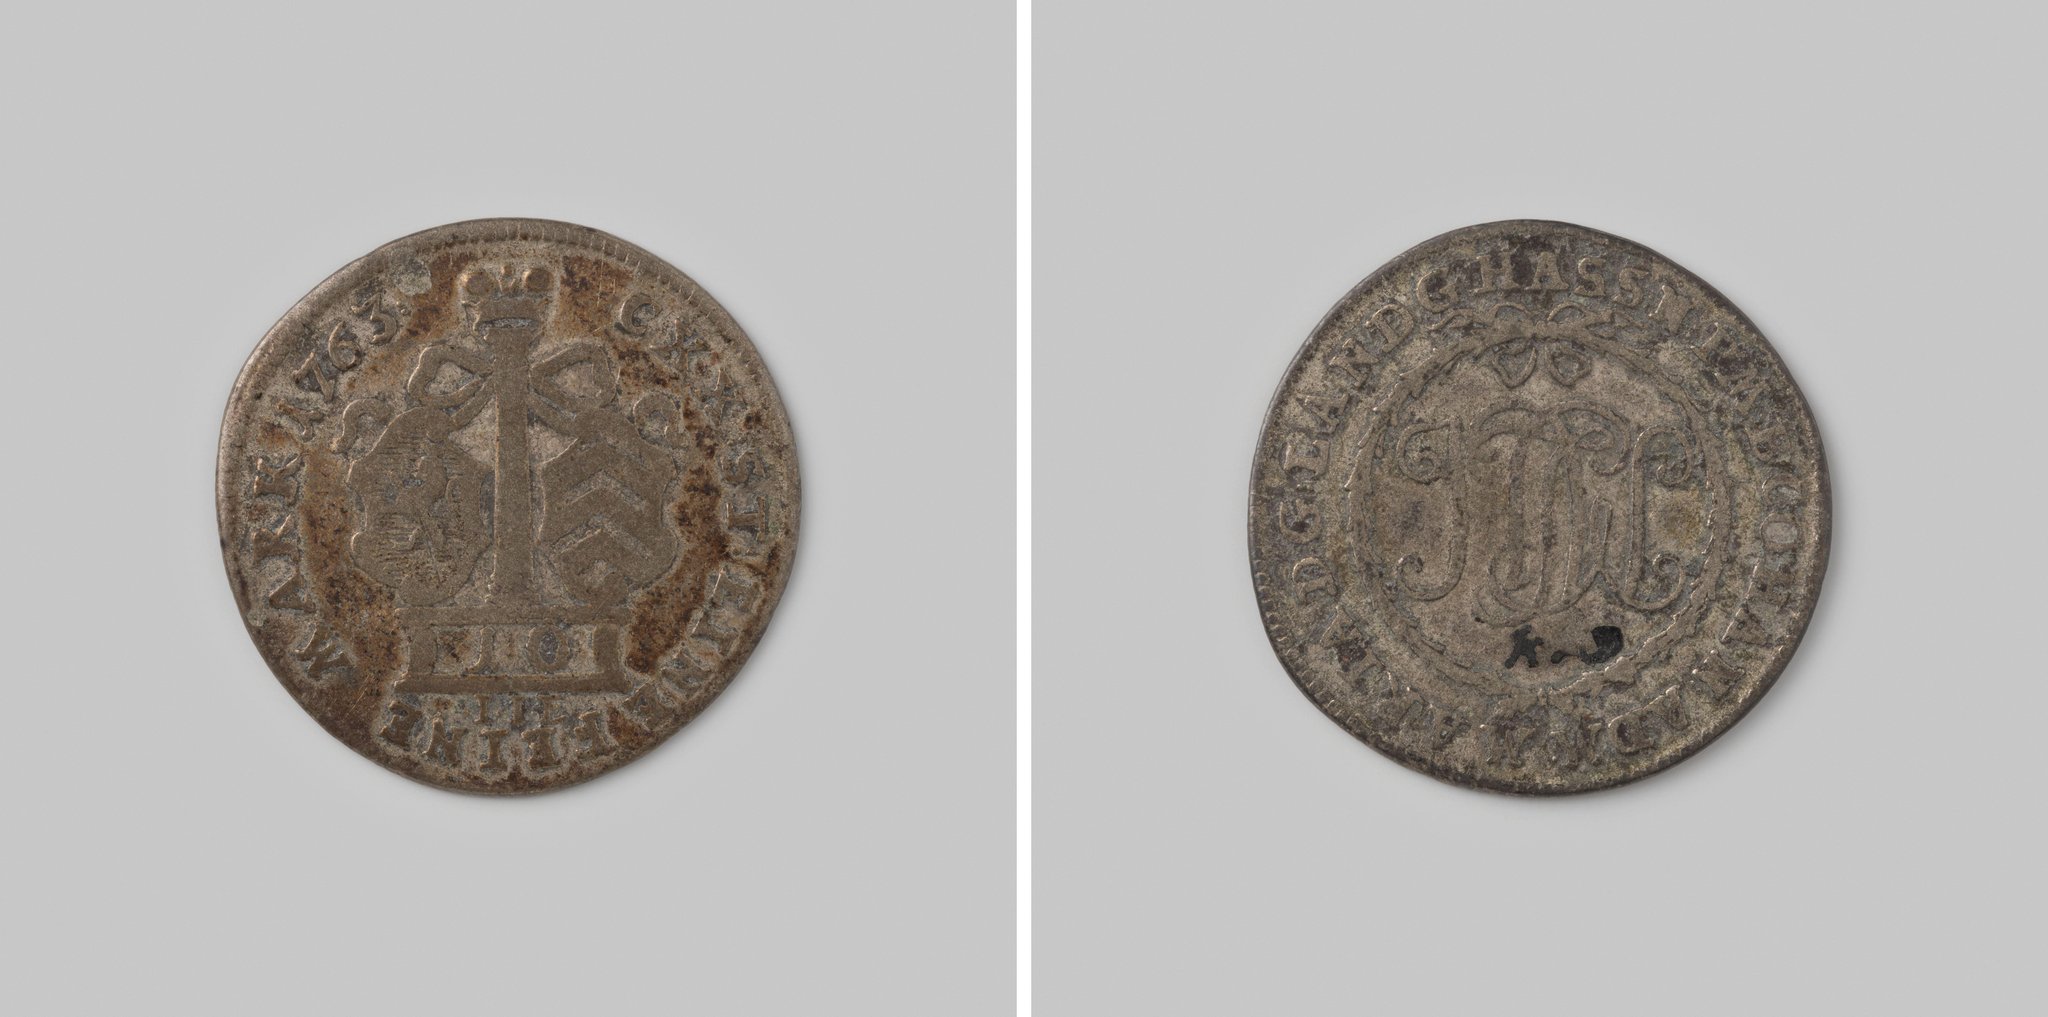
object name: coin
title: Hessen-Kassel, landgravin Maria als voogdes, zehner, 1763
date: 1767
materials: silver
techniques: striking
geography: kassel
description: Zilveren munt. Voorzijde: aan weerzijden van een gekroonde zuil op een voetstuk twee samengebonden wapenschilden. Waaarde-aanduiding en jaartal in omschrift. Keerzijde: binnen twee samengebonden takken monogram. Kabelrand.